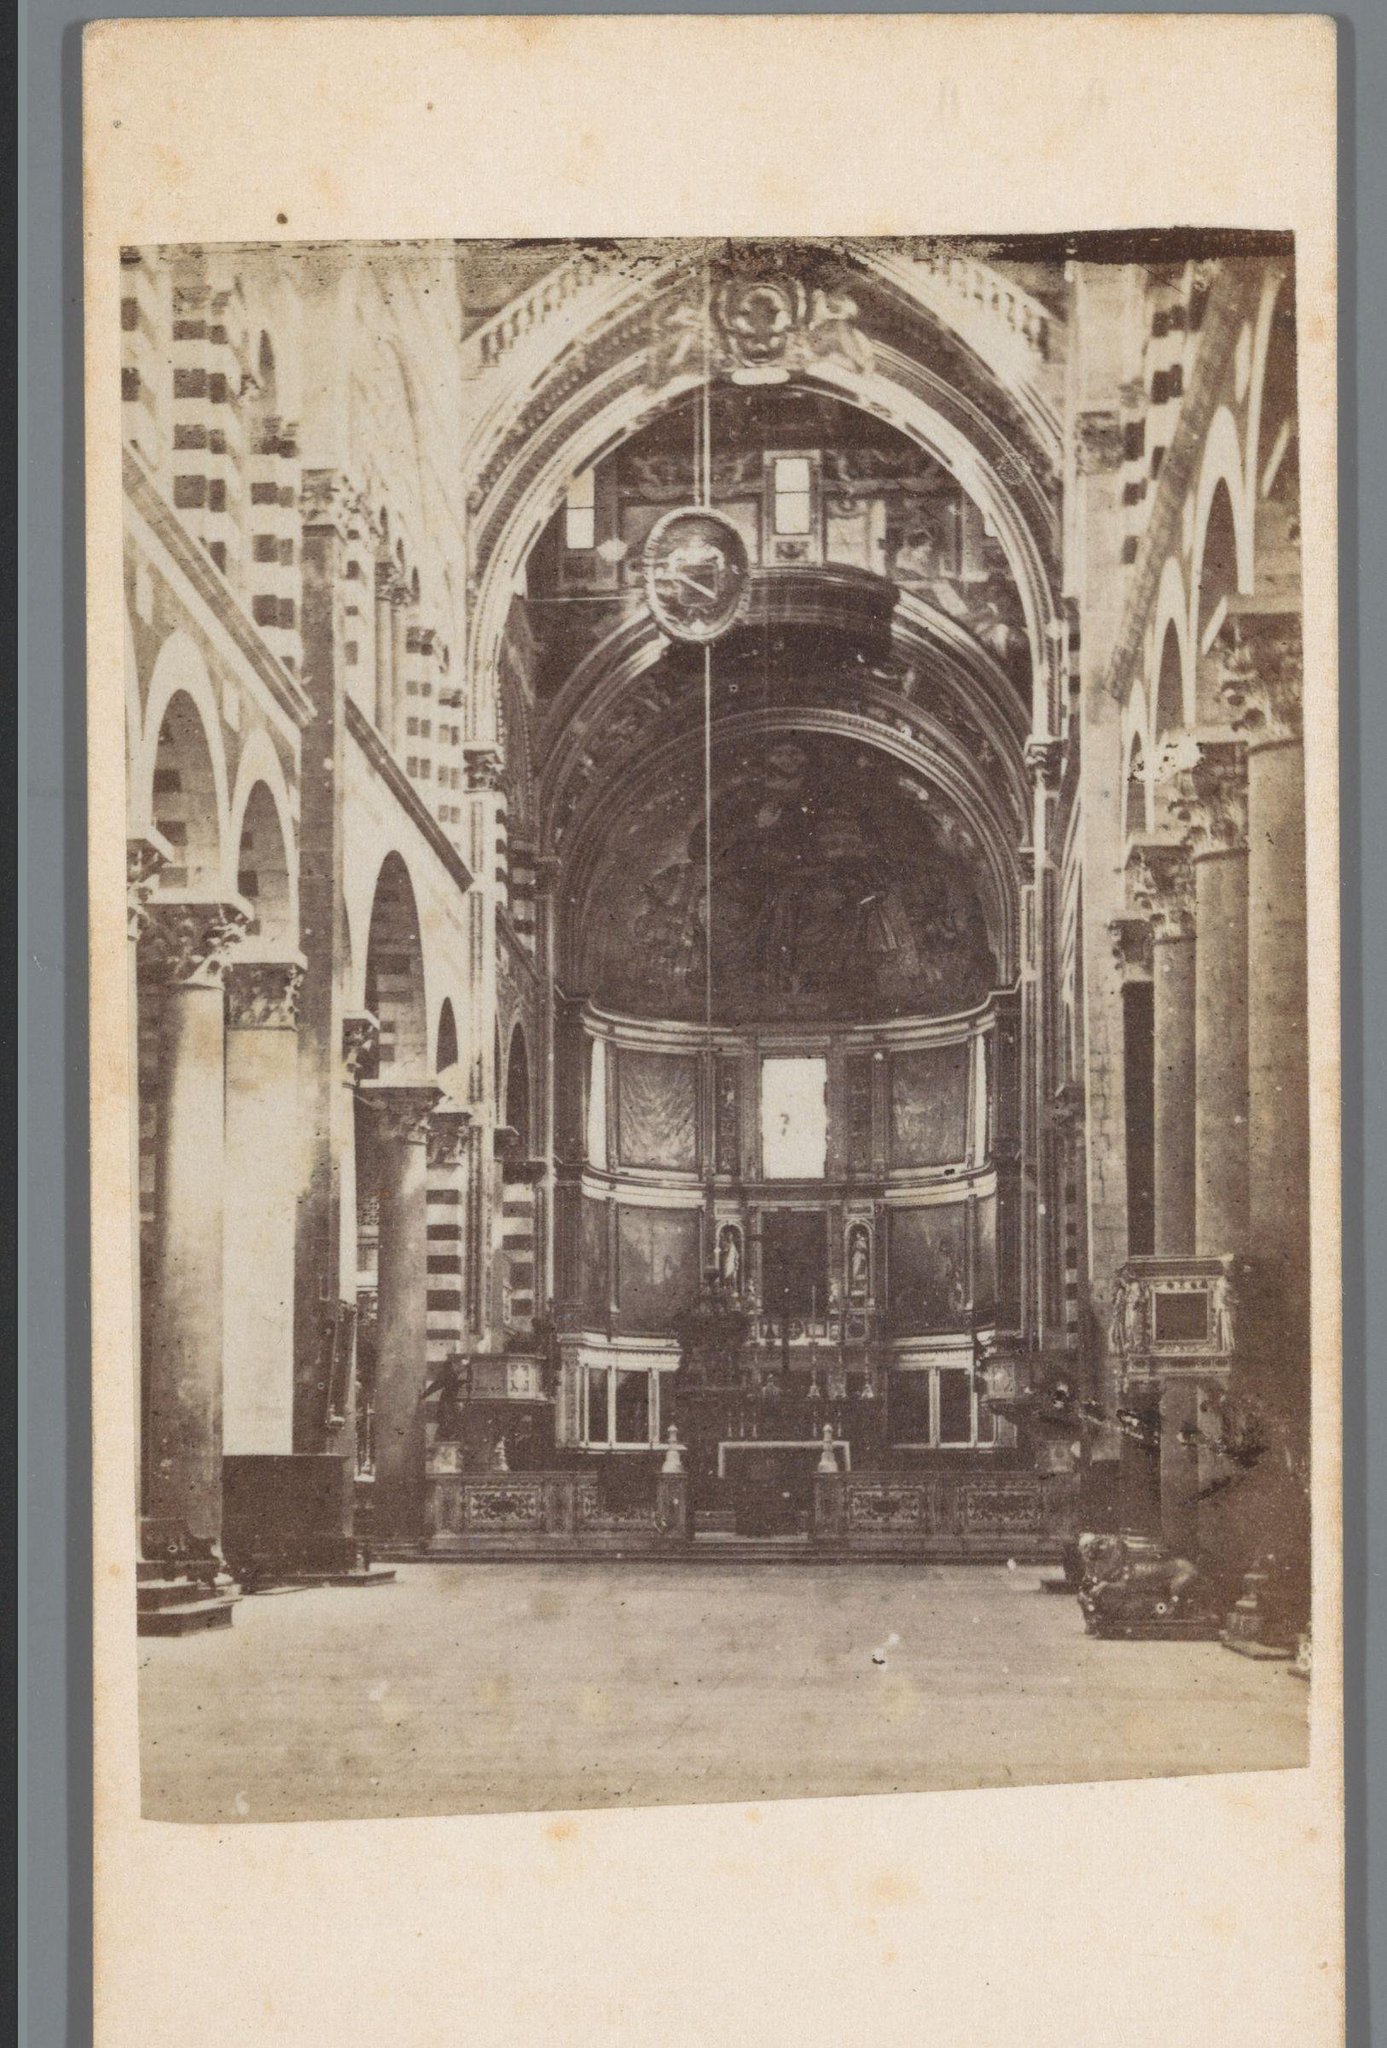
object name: carte de visite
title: Interieur van de Dom van Pisa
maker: Anonymous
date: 1855-1885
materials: cardboard, paper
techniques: albumen print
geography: pisa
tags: interior of church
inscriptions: inscription: ‘Pisa’